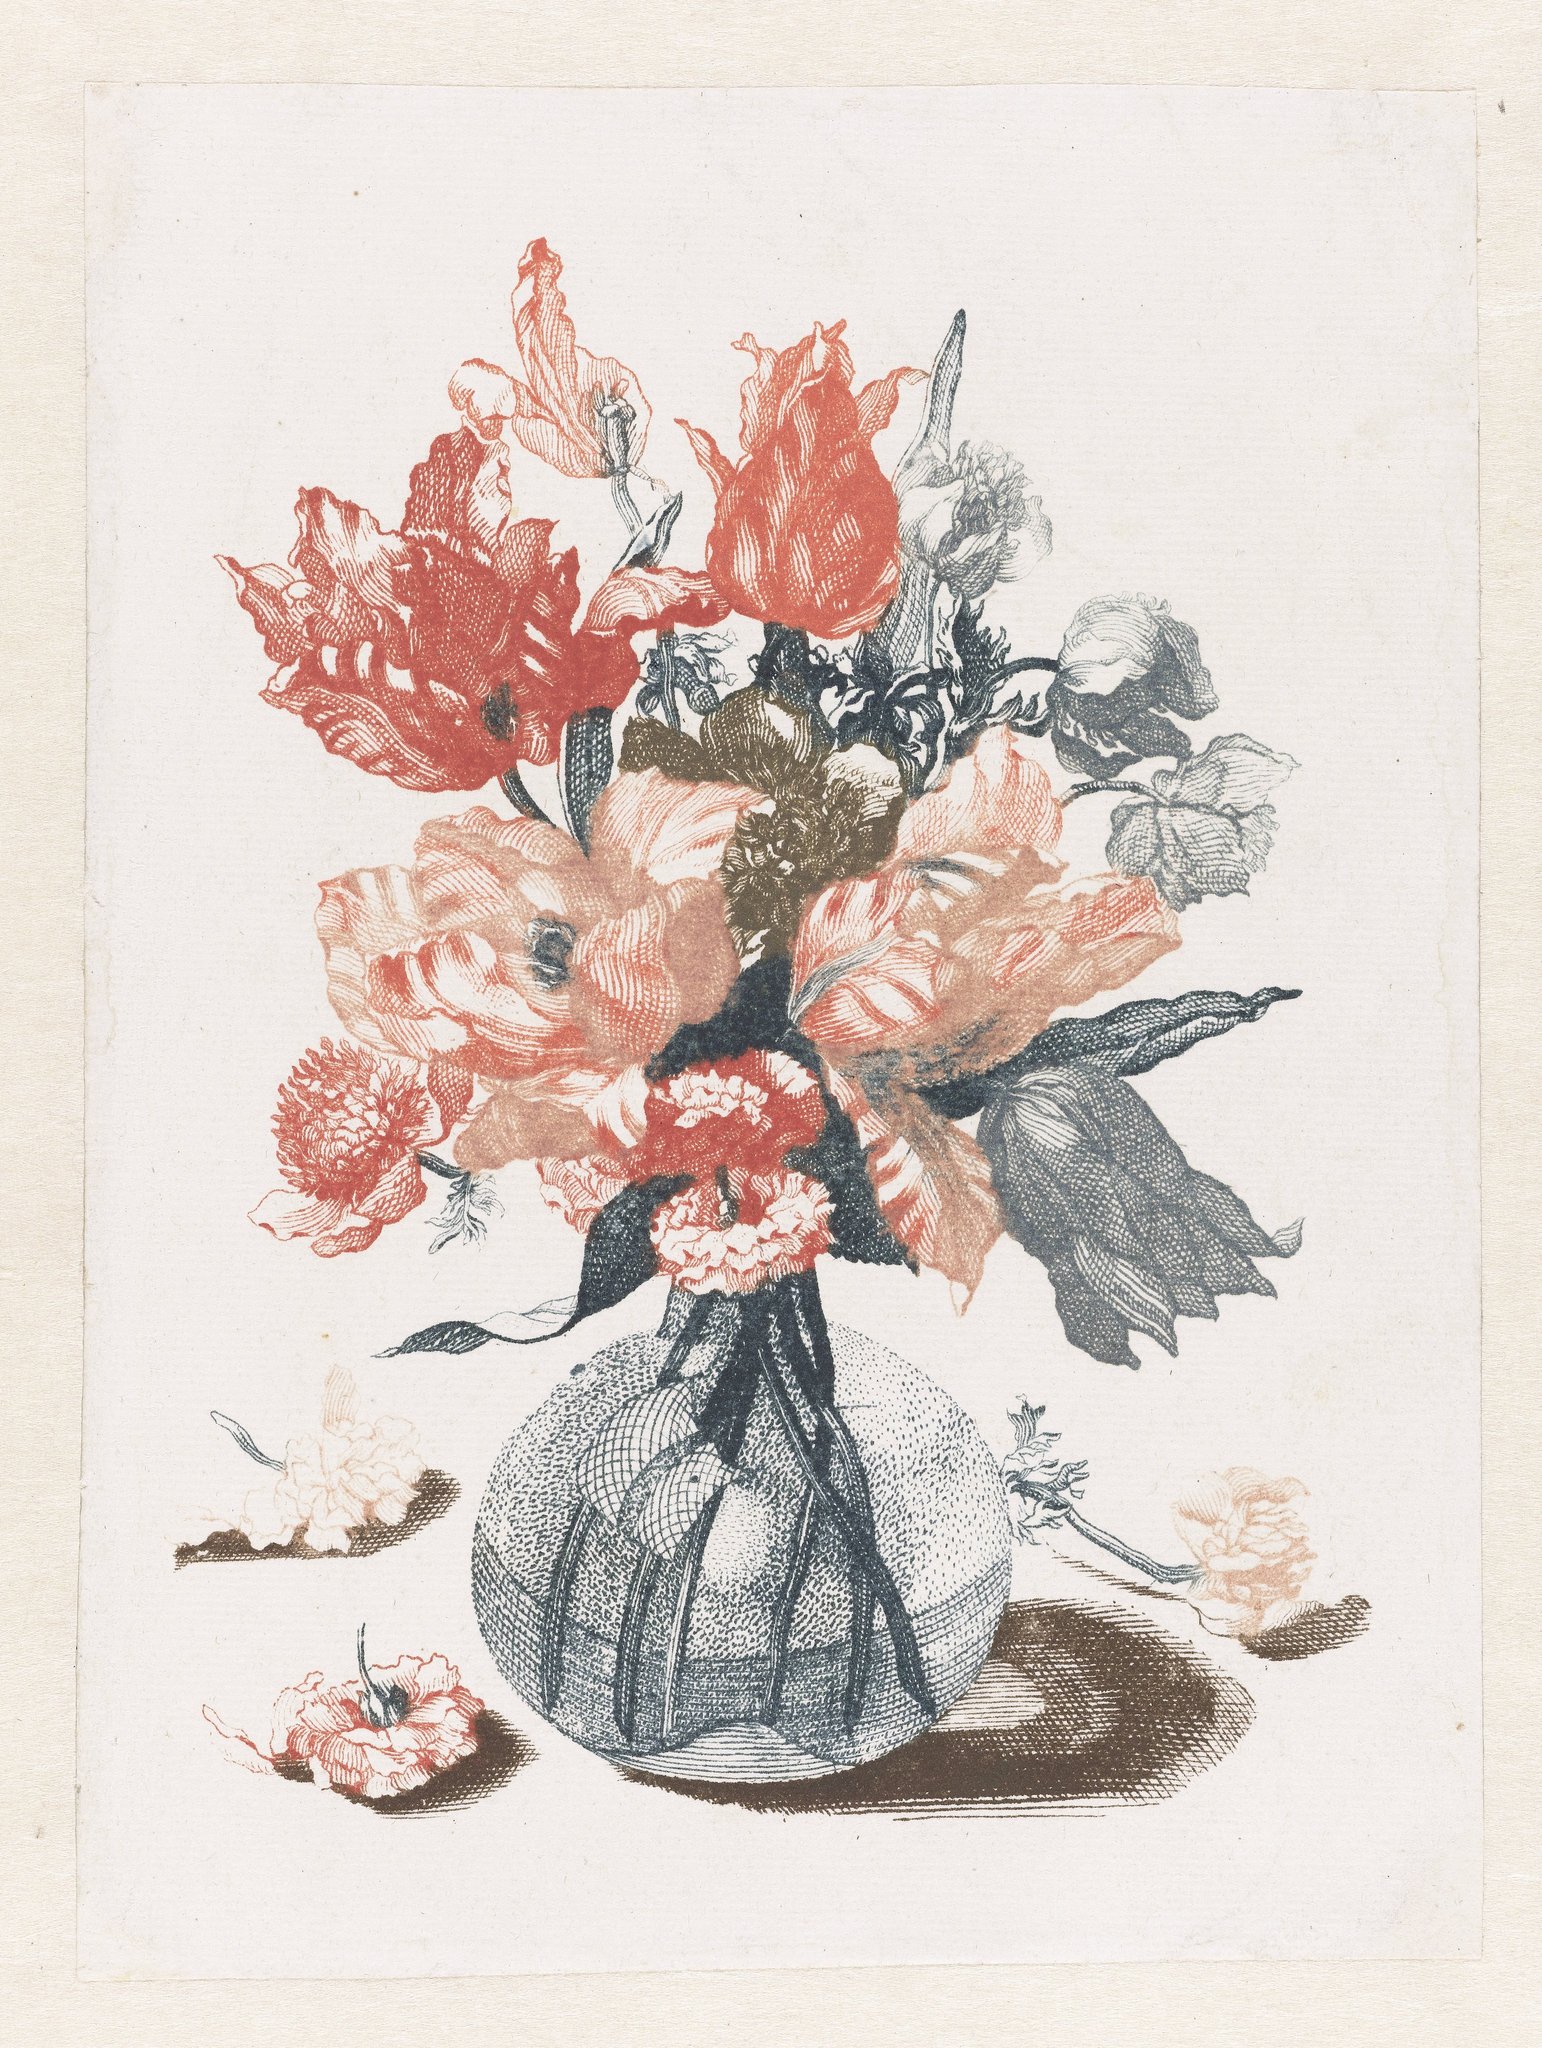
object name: print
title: Five Prints of Flowers in Glass Vases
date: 1688-1698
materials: paper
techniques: engraving, etching, lithography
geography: netherlands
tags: flowers in a vase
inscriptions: collector's mark: Lugt 2228, collector's mark: Lugt 2760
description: Johannes Teyler from Nijmegen was educated as a philosopher and mathematician, but also worked later as a military engineer. He invented a method for printing impressions in colour, for which he received a patent in 1688. The colours had to be applied to the copper plate by hand for each individual impression. Because this was very labour intensive, his colour printing process found little following.